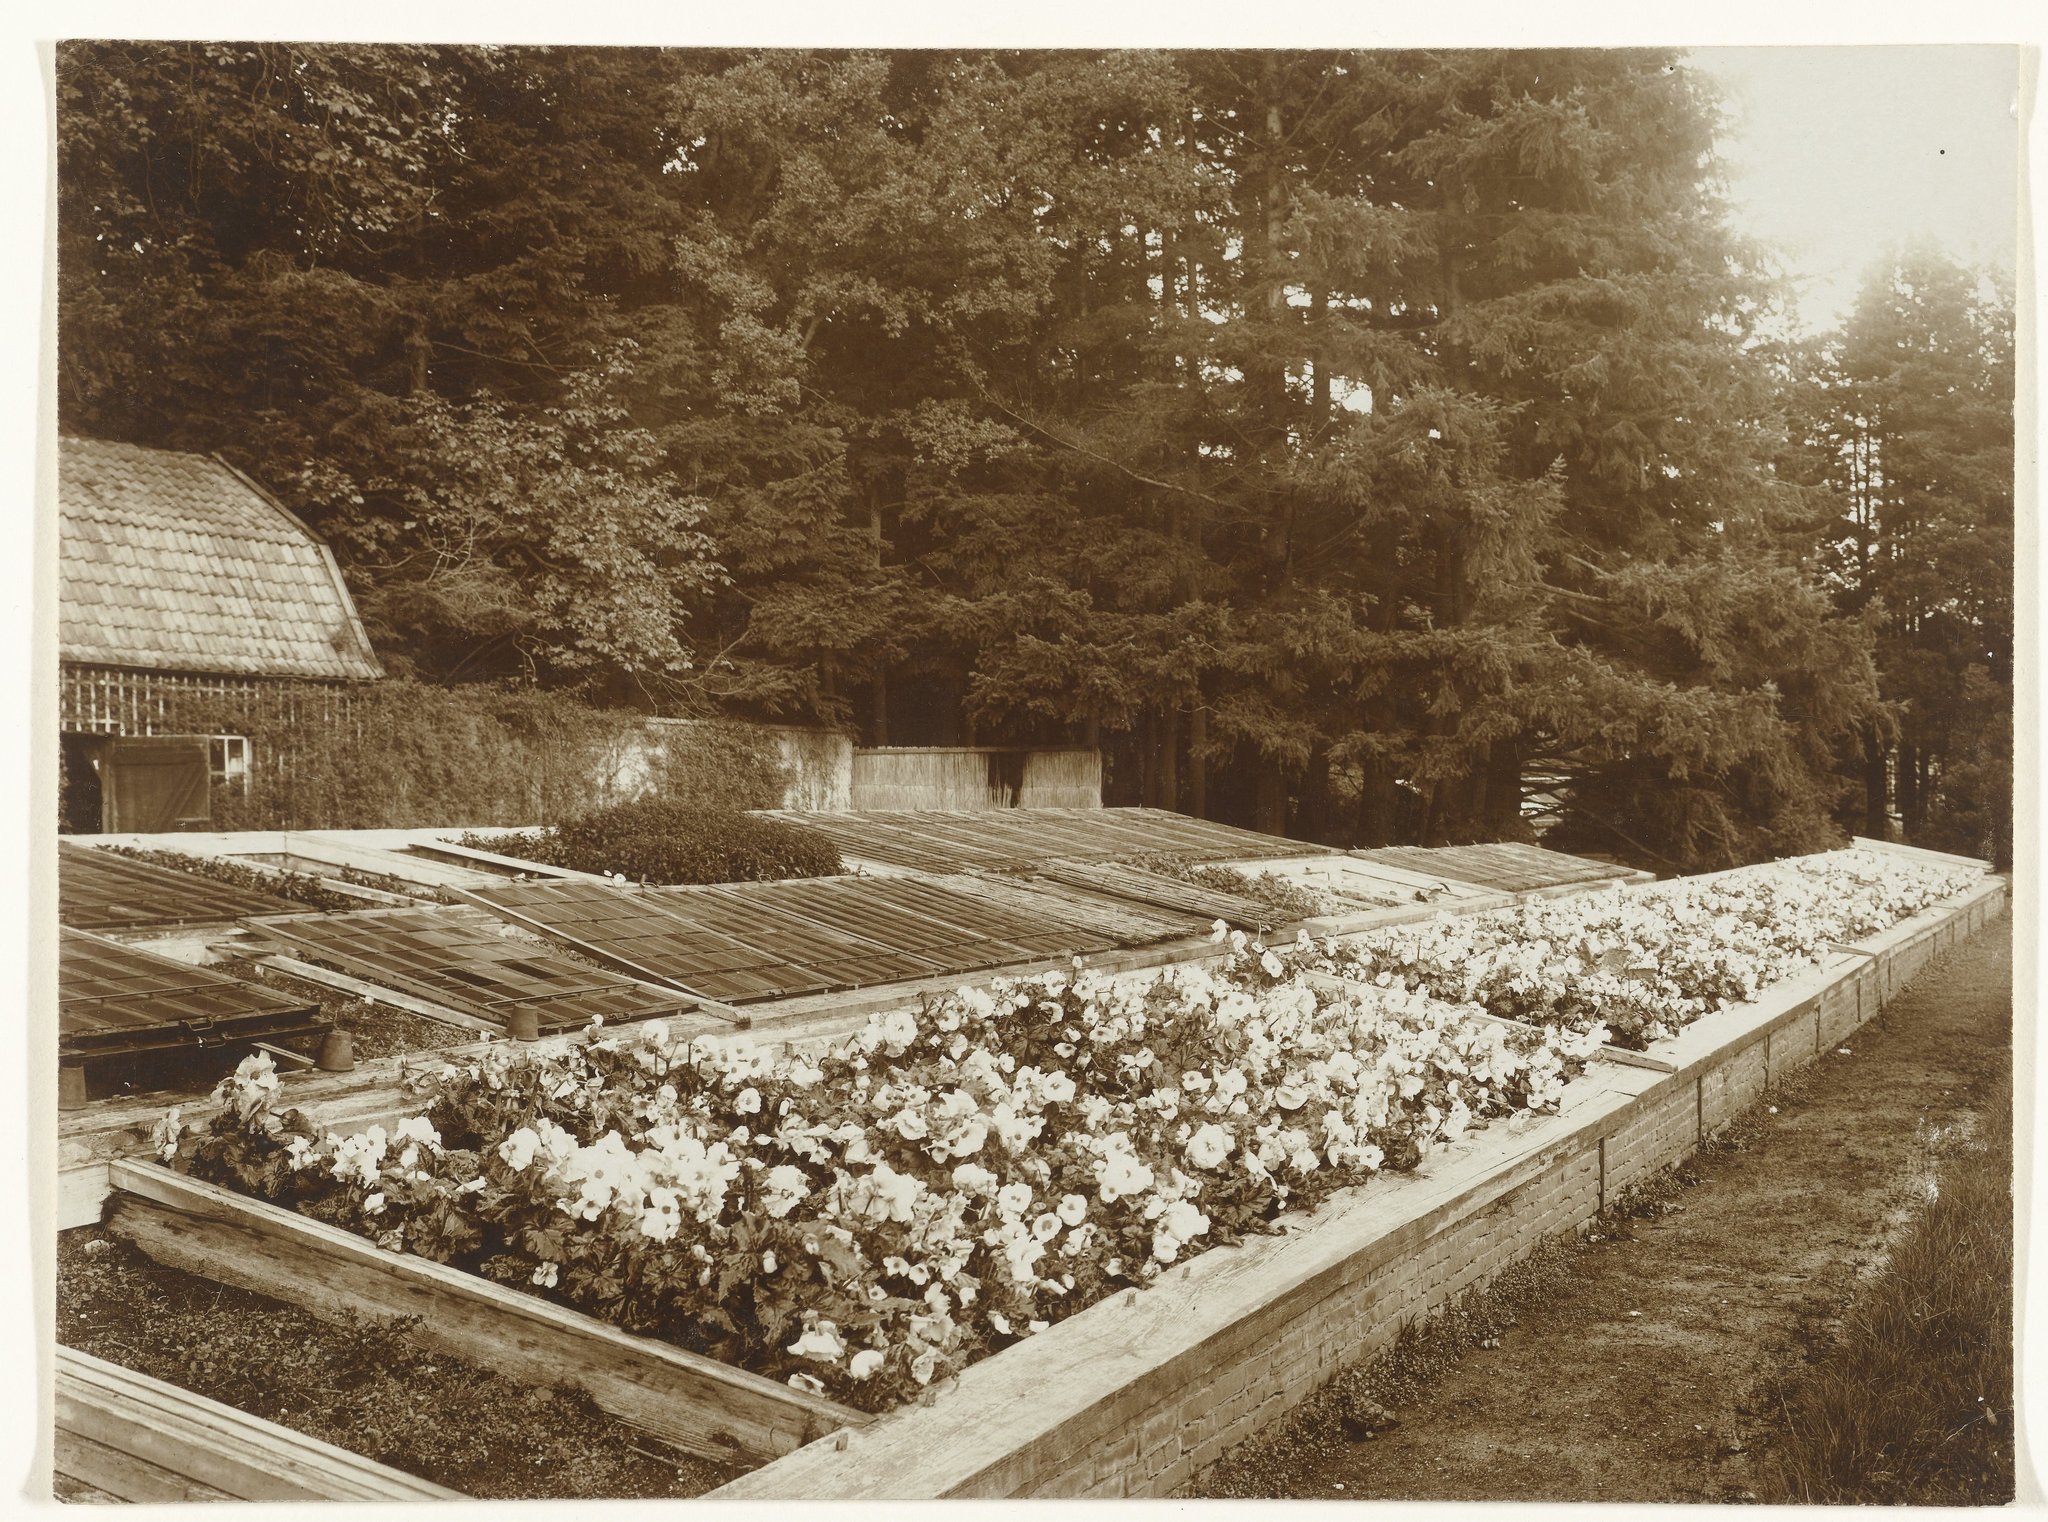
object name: photograph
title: Bakken met begonia's in het park van Paleis Het Loo in Apeldoorn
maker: richard tepe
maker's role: fotograaf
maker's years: 1864-1952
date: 1900-1930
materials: paper, photographic support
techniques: gelatin silver print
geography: netherlands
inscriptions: annotation: ‘Bloemesteeg in / het Koninklijk Park Het Loo / te Het Loo / op den voorgrond / bakken met Begonias’, signature: ‘foto / R Tepe’